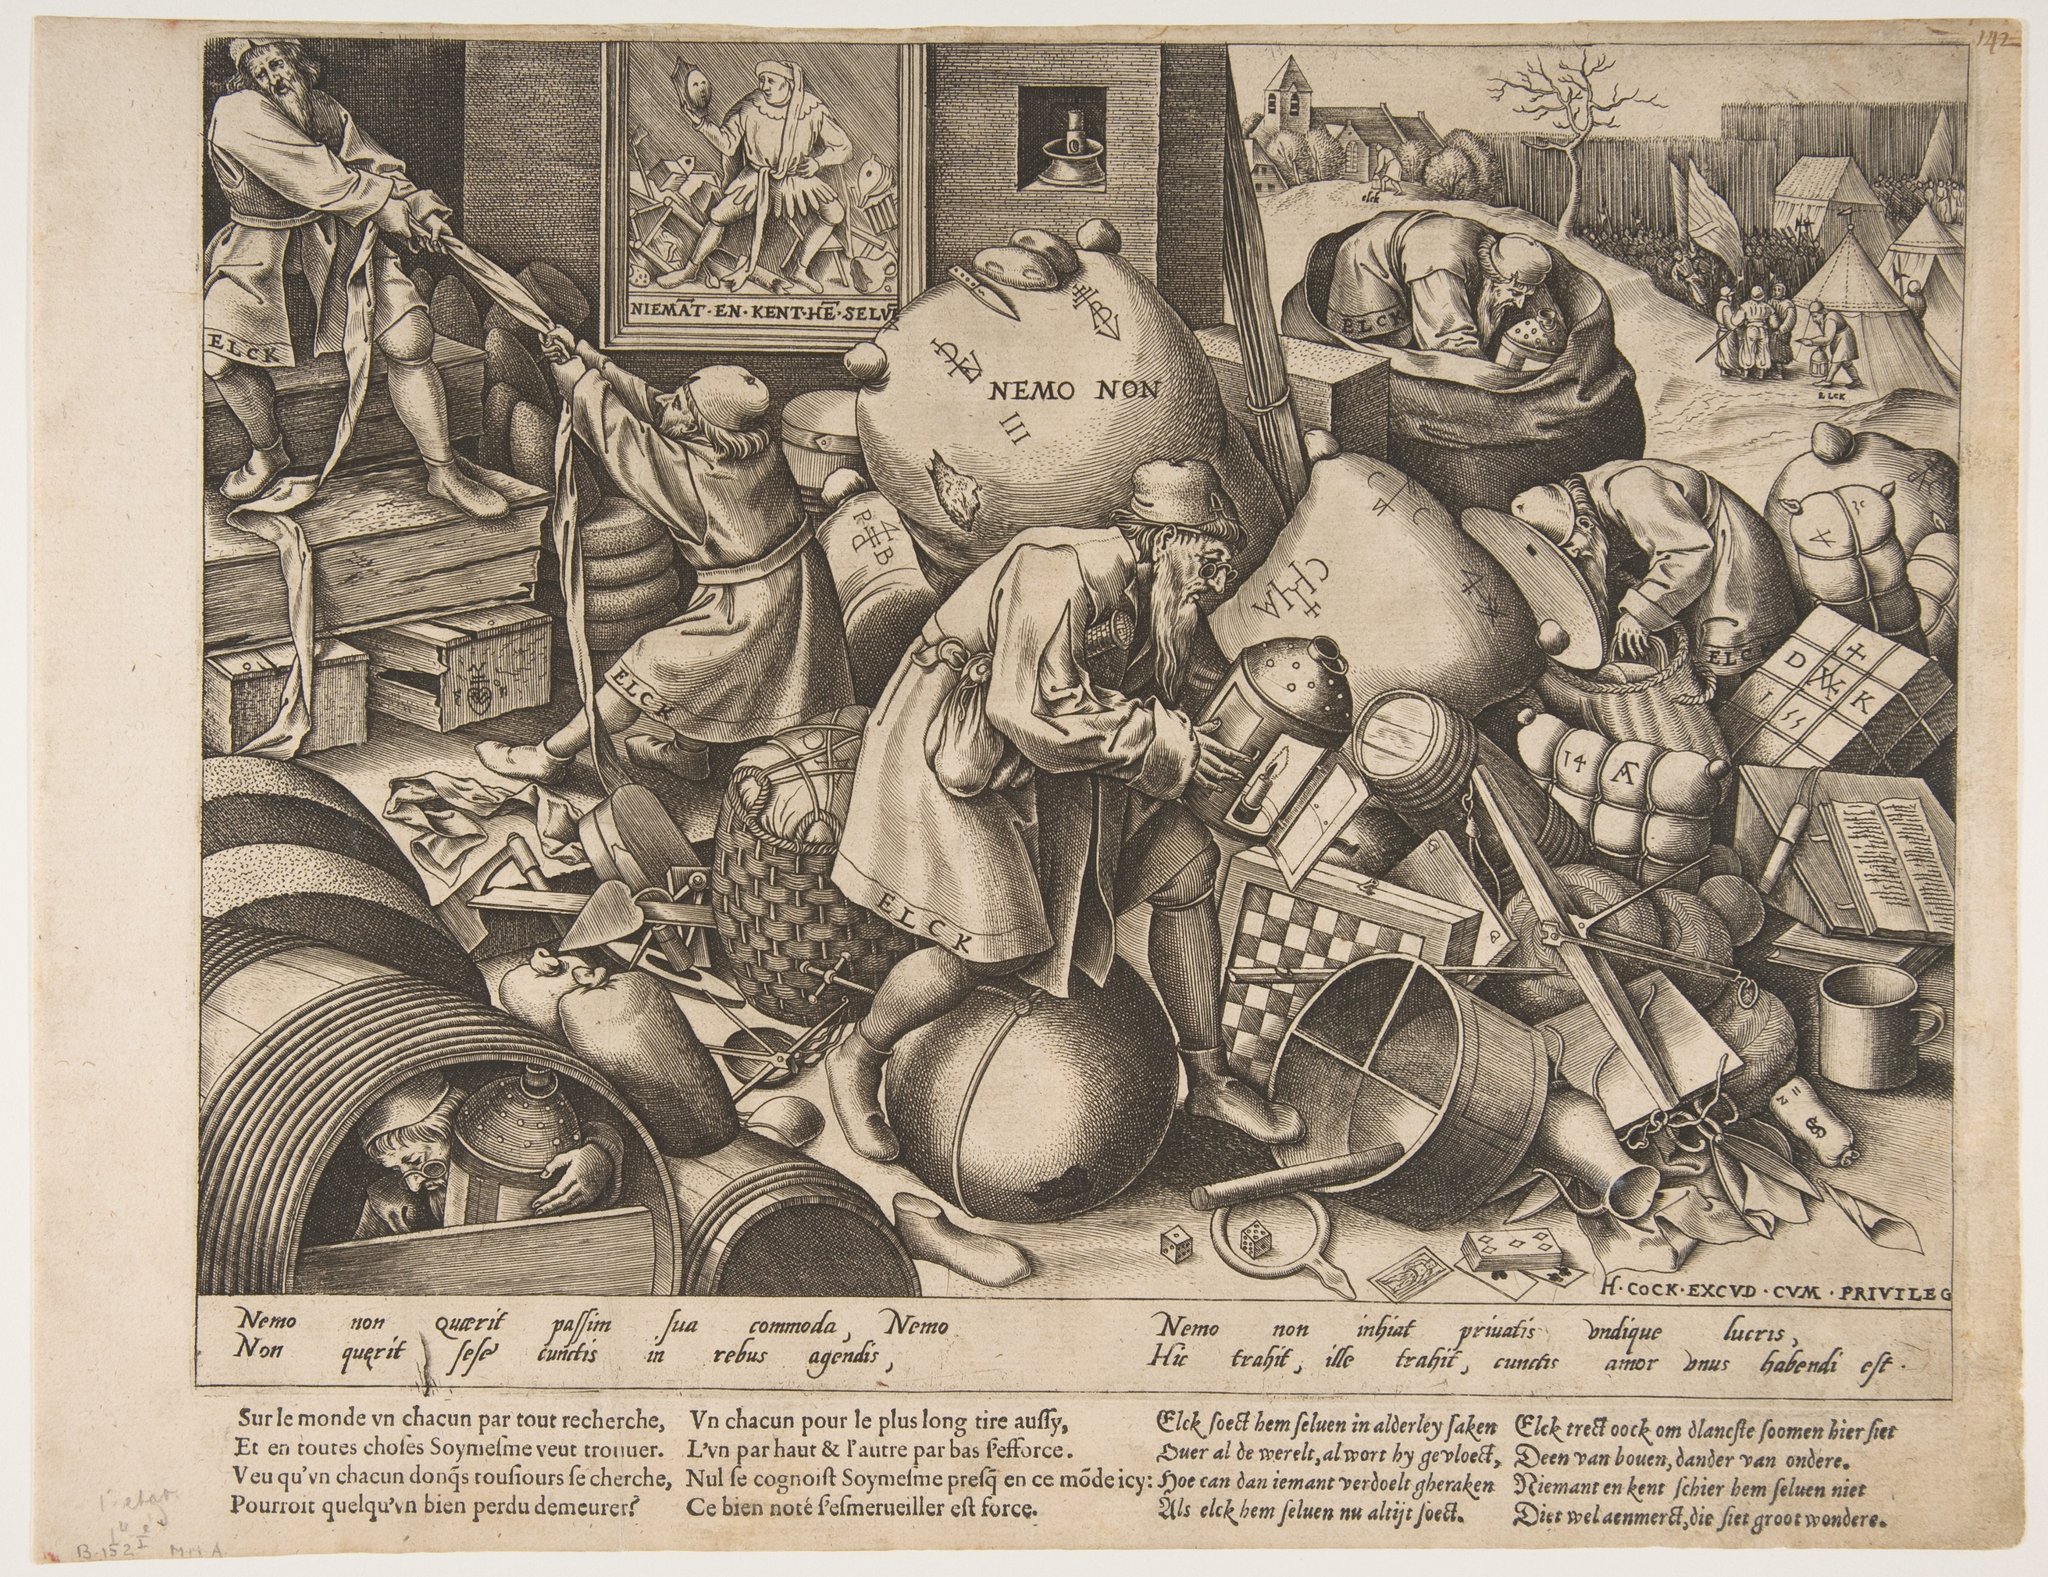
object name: print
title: Everyman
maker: pieter bruegel the elder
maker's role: artist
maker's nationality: netherlandish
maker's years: 1525-1569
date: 1558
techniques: engraving, letterpress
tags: men,working